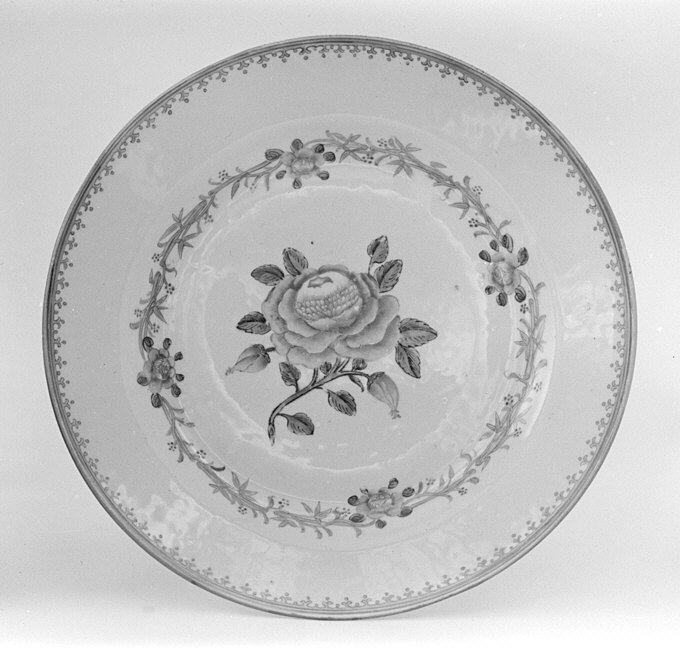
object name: plate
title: Plate (one of two)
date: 1750-1770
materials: hard paste porcelain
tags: roses